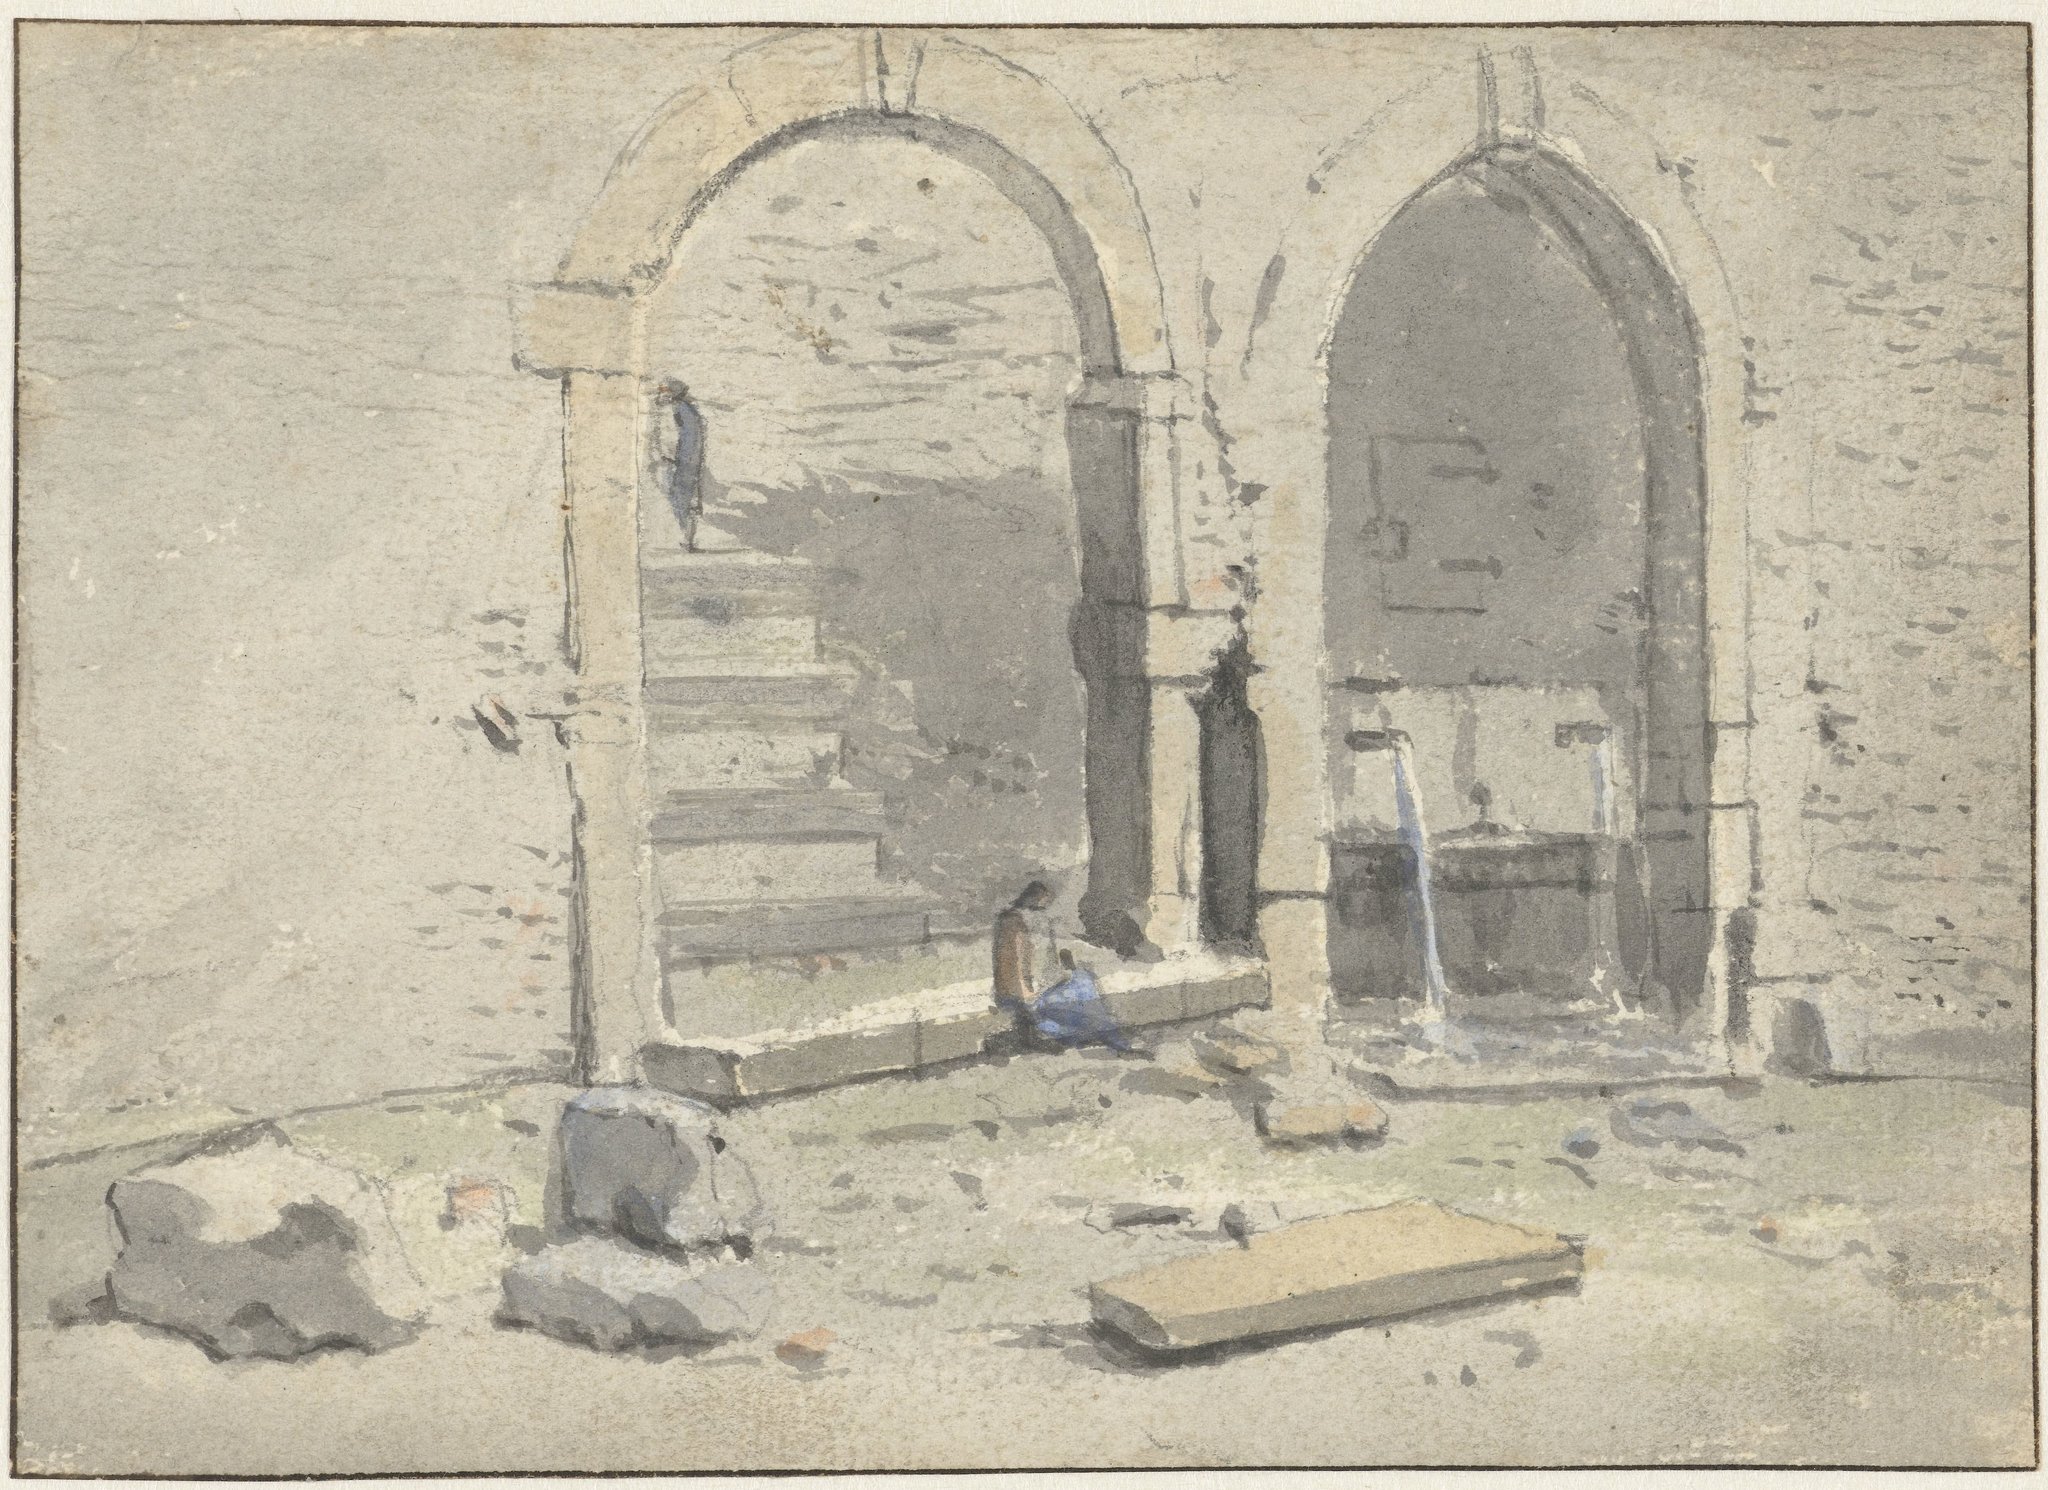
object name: drawing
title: Fontein tegen een stadsmuur, waarin een trap is gebouwd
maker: theodoor wilkens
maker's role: draughtsman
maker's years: 1690-1748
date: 1700-1748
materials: ink, paper, watercolor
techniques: brush, pen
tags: city-walls